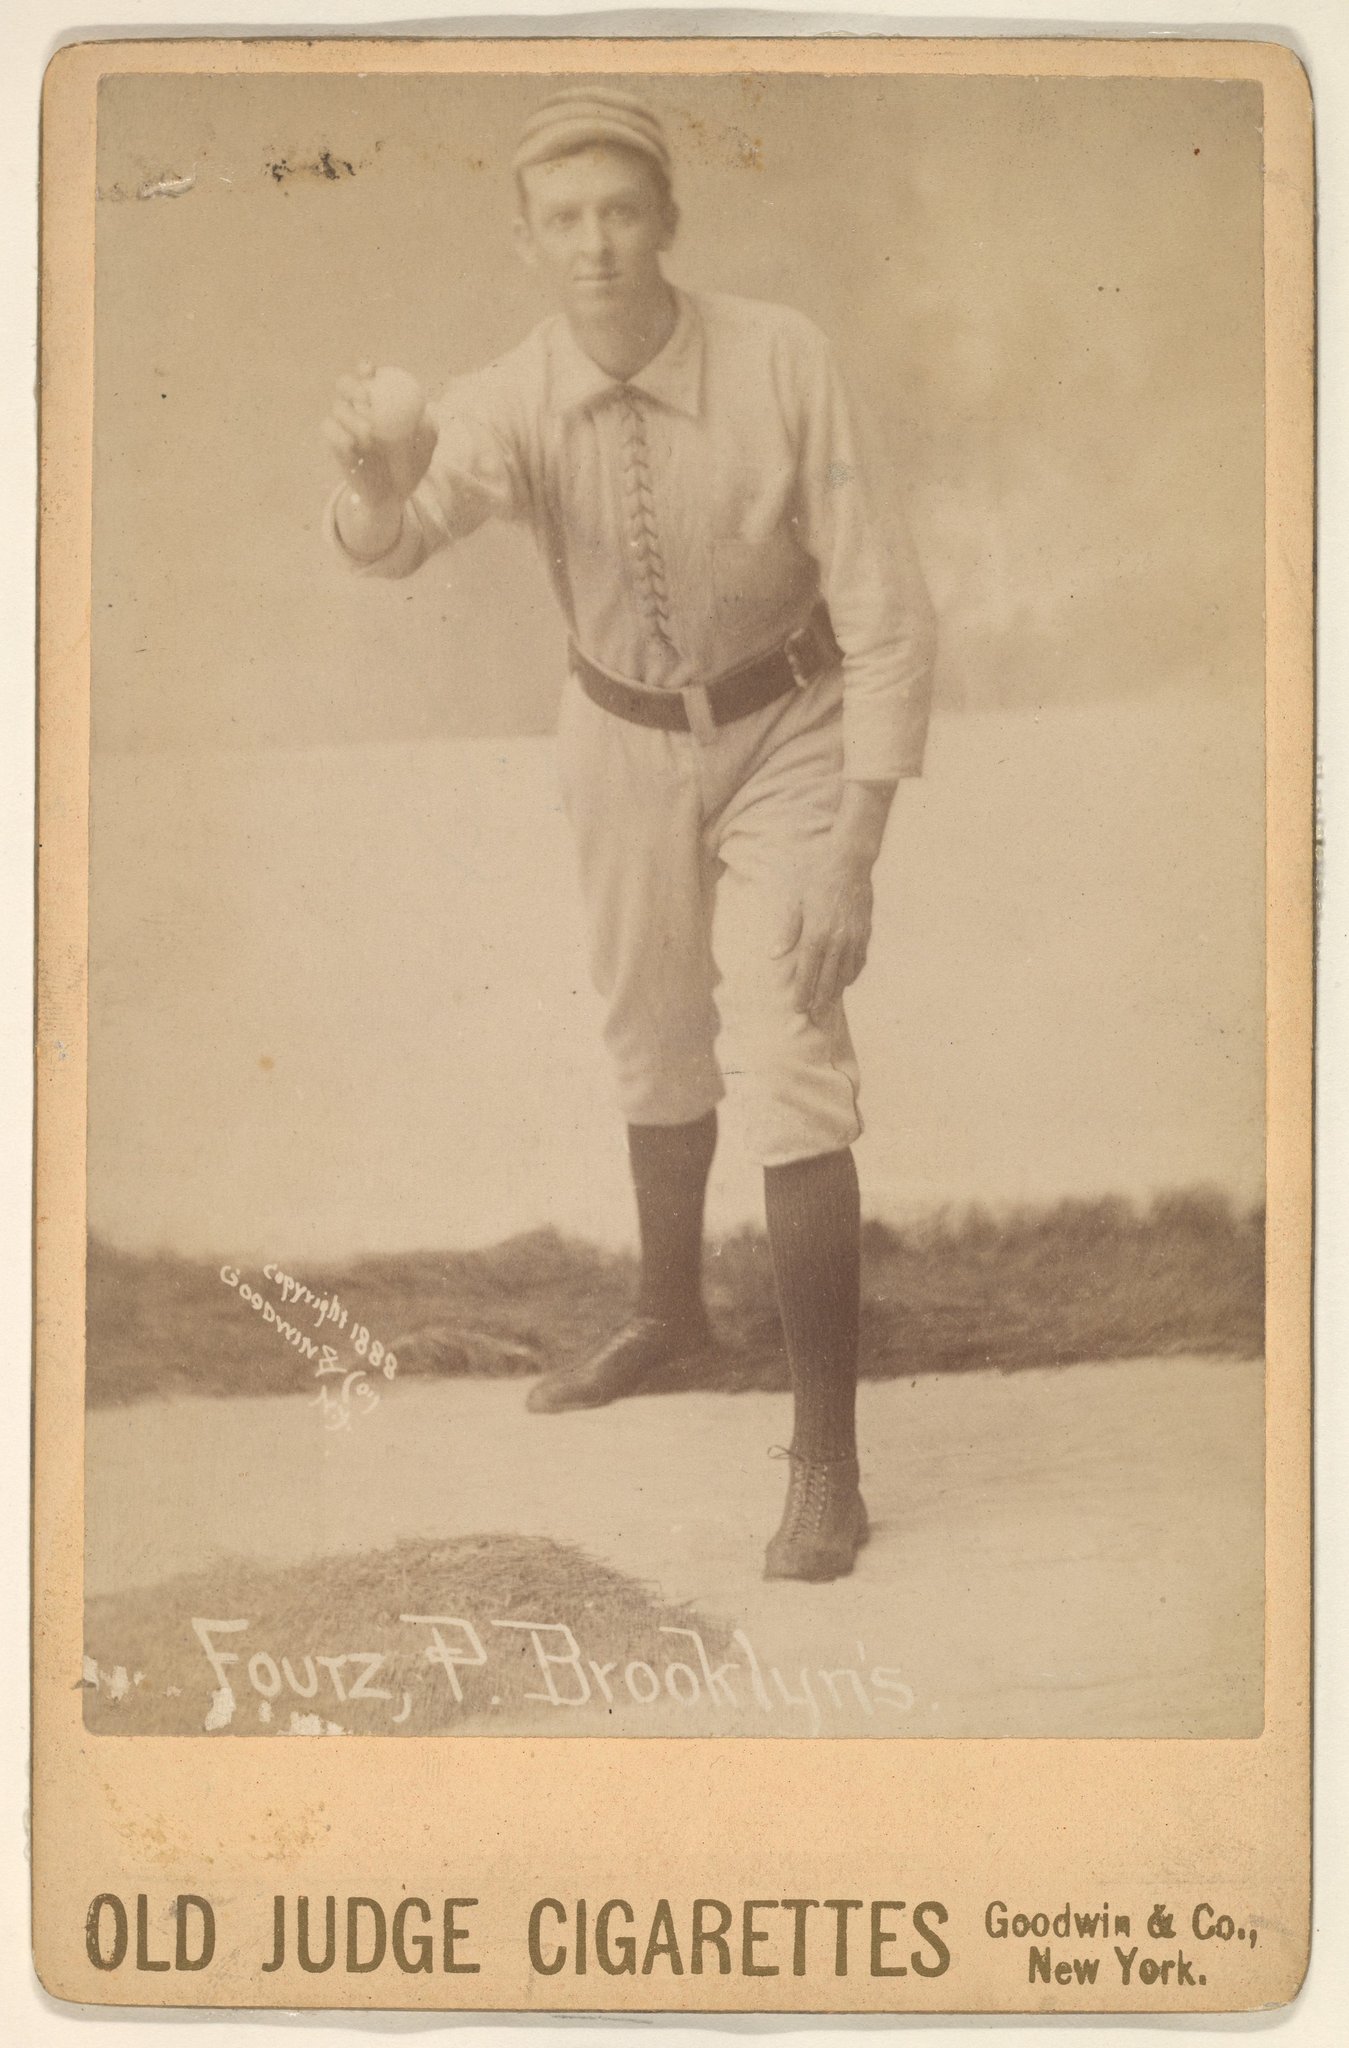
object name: baseball card, photograph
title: David Luther Foutz, Pitcher, Brooklyn, from the series Old Judge Cigarettes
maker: goodwin & company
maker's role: publisher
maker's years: 1850-1950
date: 1888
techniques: albumen silver print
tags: men,portraits,baseball,athletes